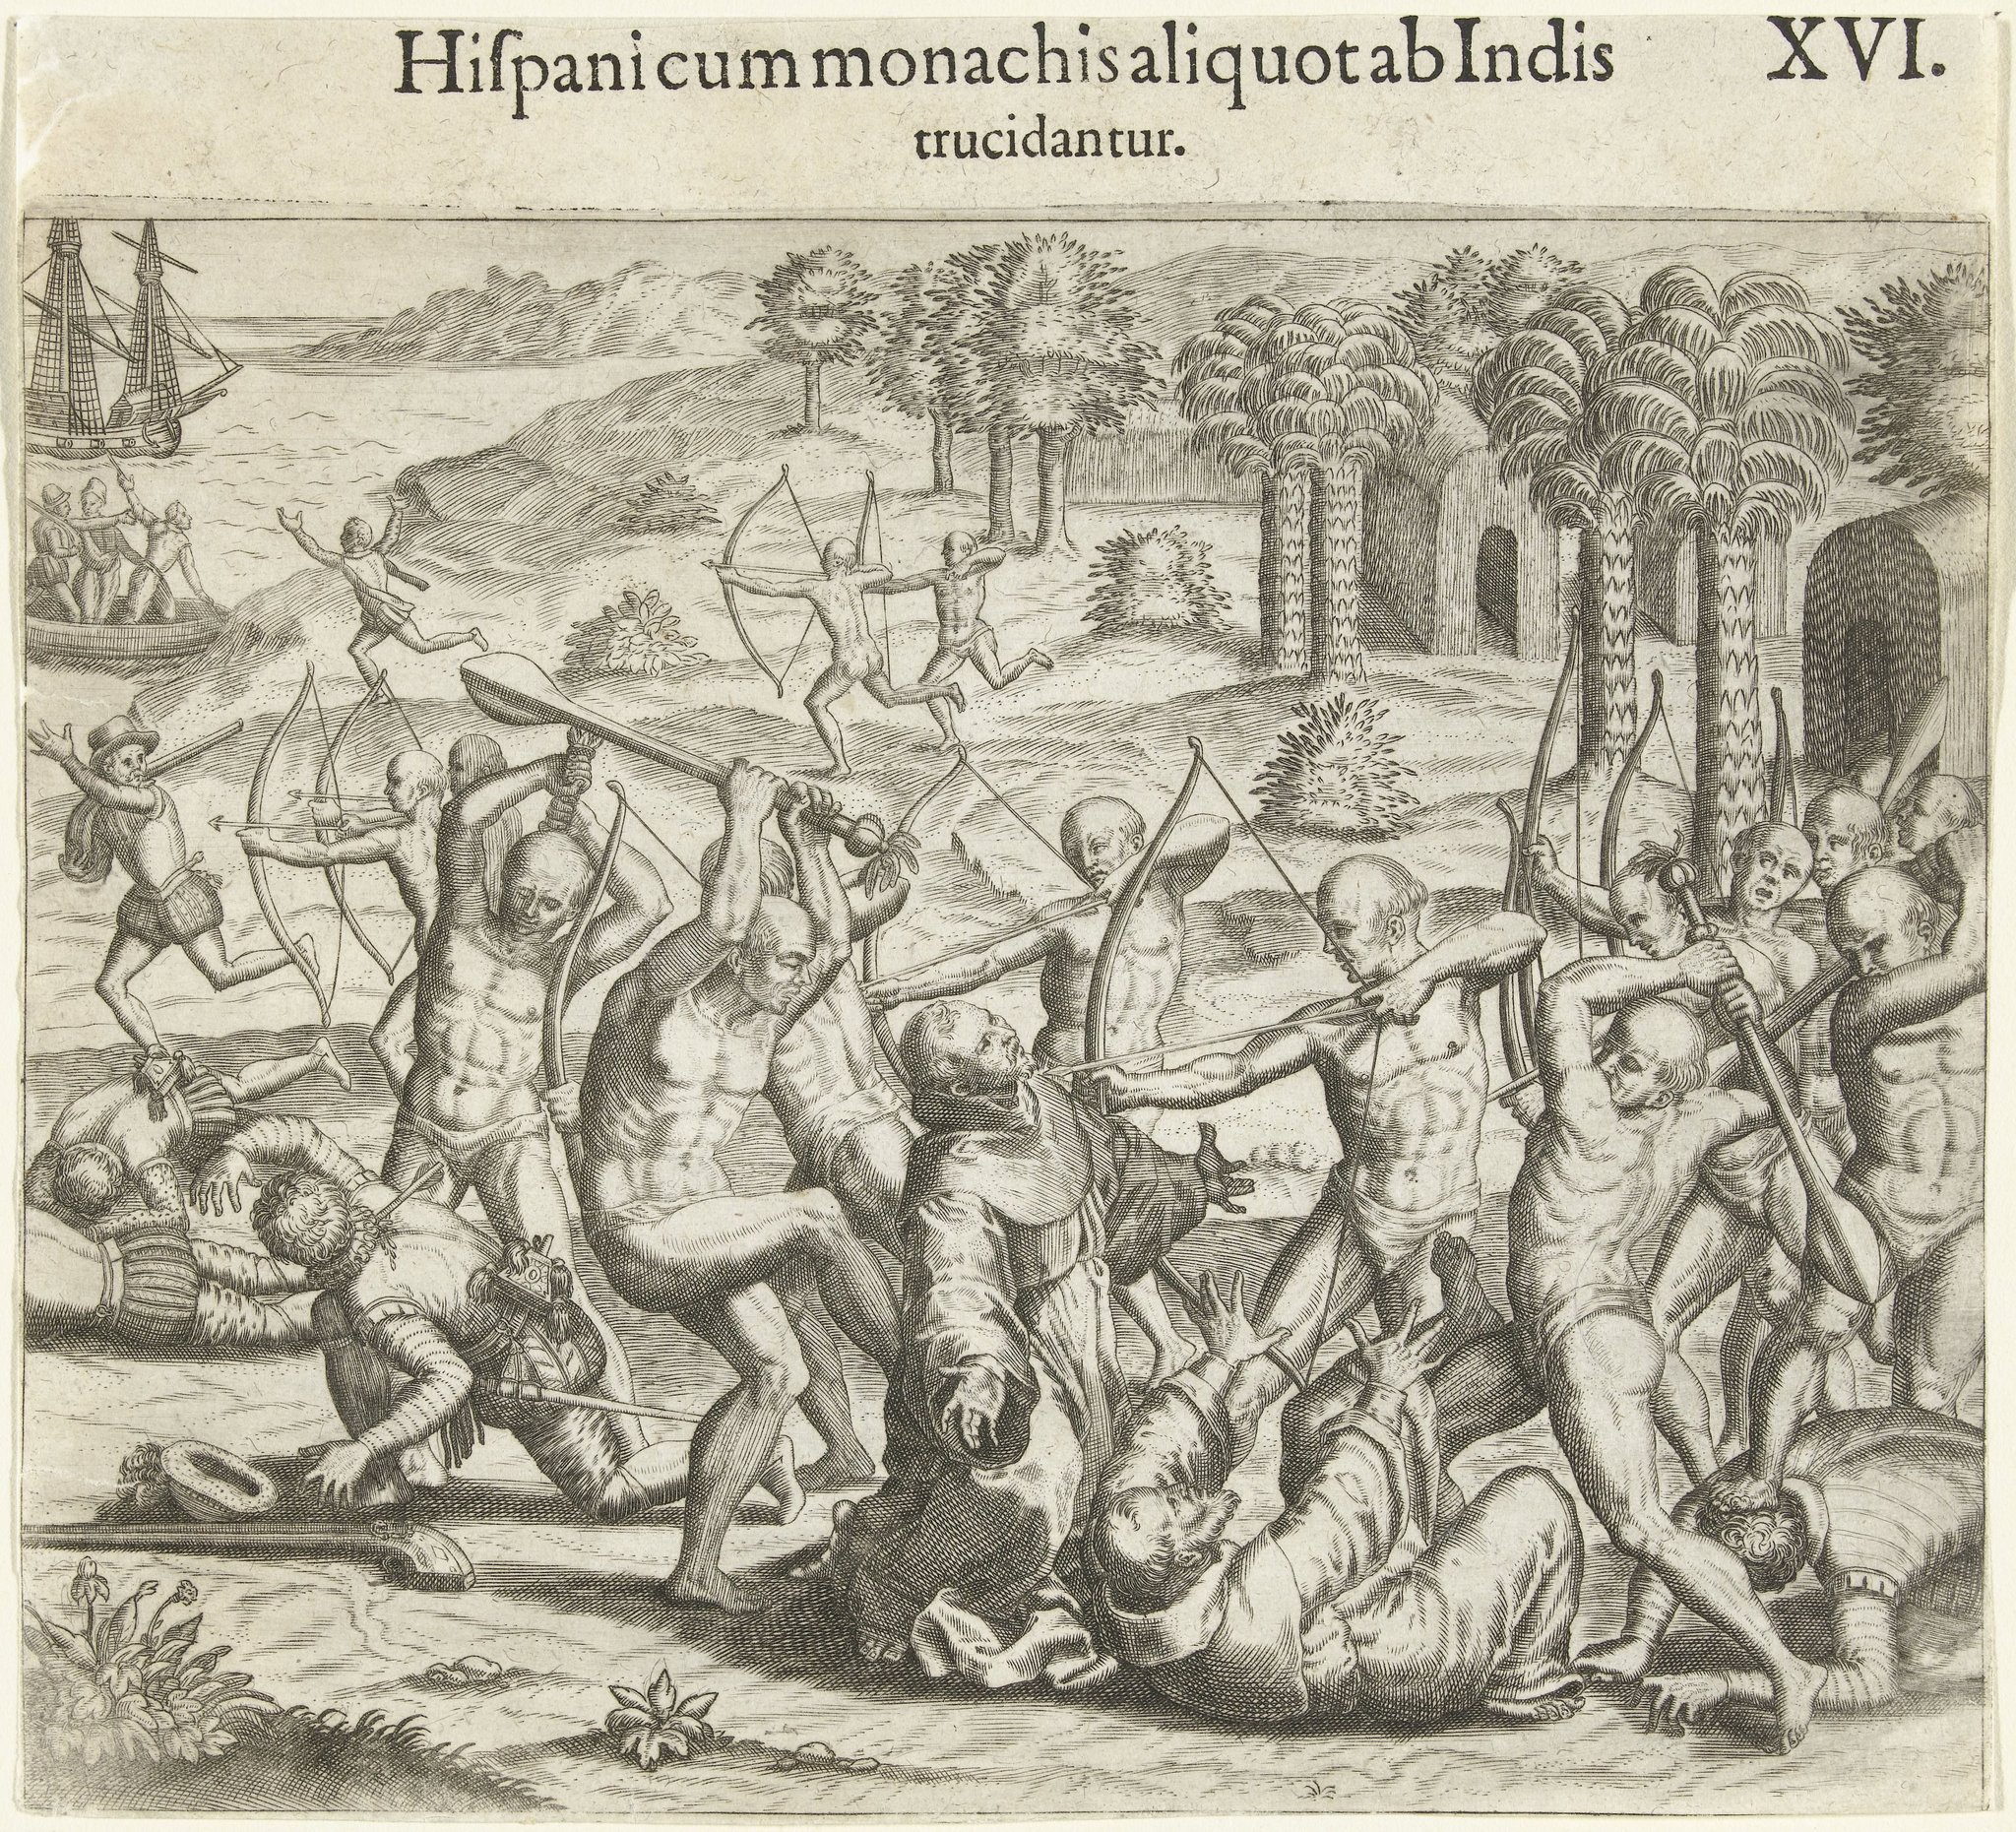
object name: print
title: India occidentalis IV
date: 1594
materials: paper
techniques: engraving, letterpress printing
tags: archer's weapons: bow and arrow, indigenous peoples of north america, monk(s), friar(s), indigenous peoples of central america, massacre ~ war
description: Afkomstig uit: Collectiones peregrinationum in Indiam occidentalem, dl. 4: Girolamo Benzoni, Americae pars quarta. Sive, Insignis & admiranda historia de reperta primum occidentali India à Christophoro Columbo. Frankfurt am Main: T. de Bry, 1594. De centrale knieldende monnik is gekopieerd naar de prent van de 'Stigmatisatie van de Heilige Franciscus' door Federico Barocci (ca. 1581-1585).